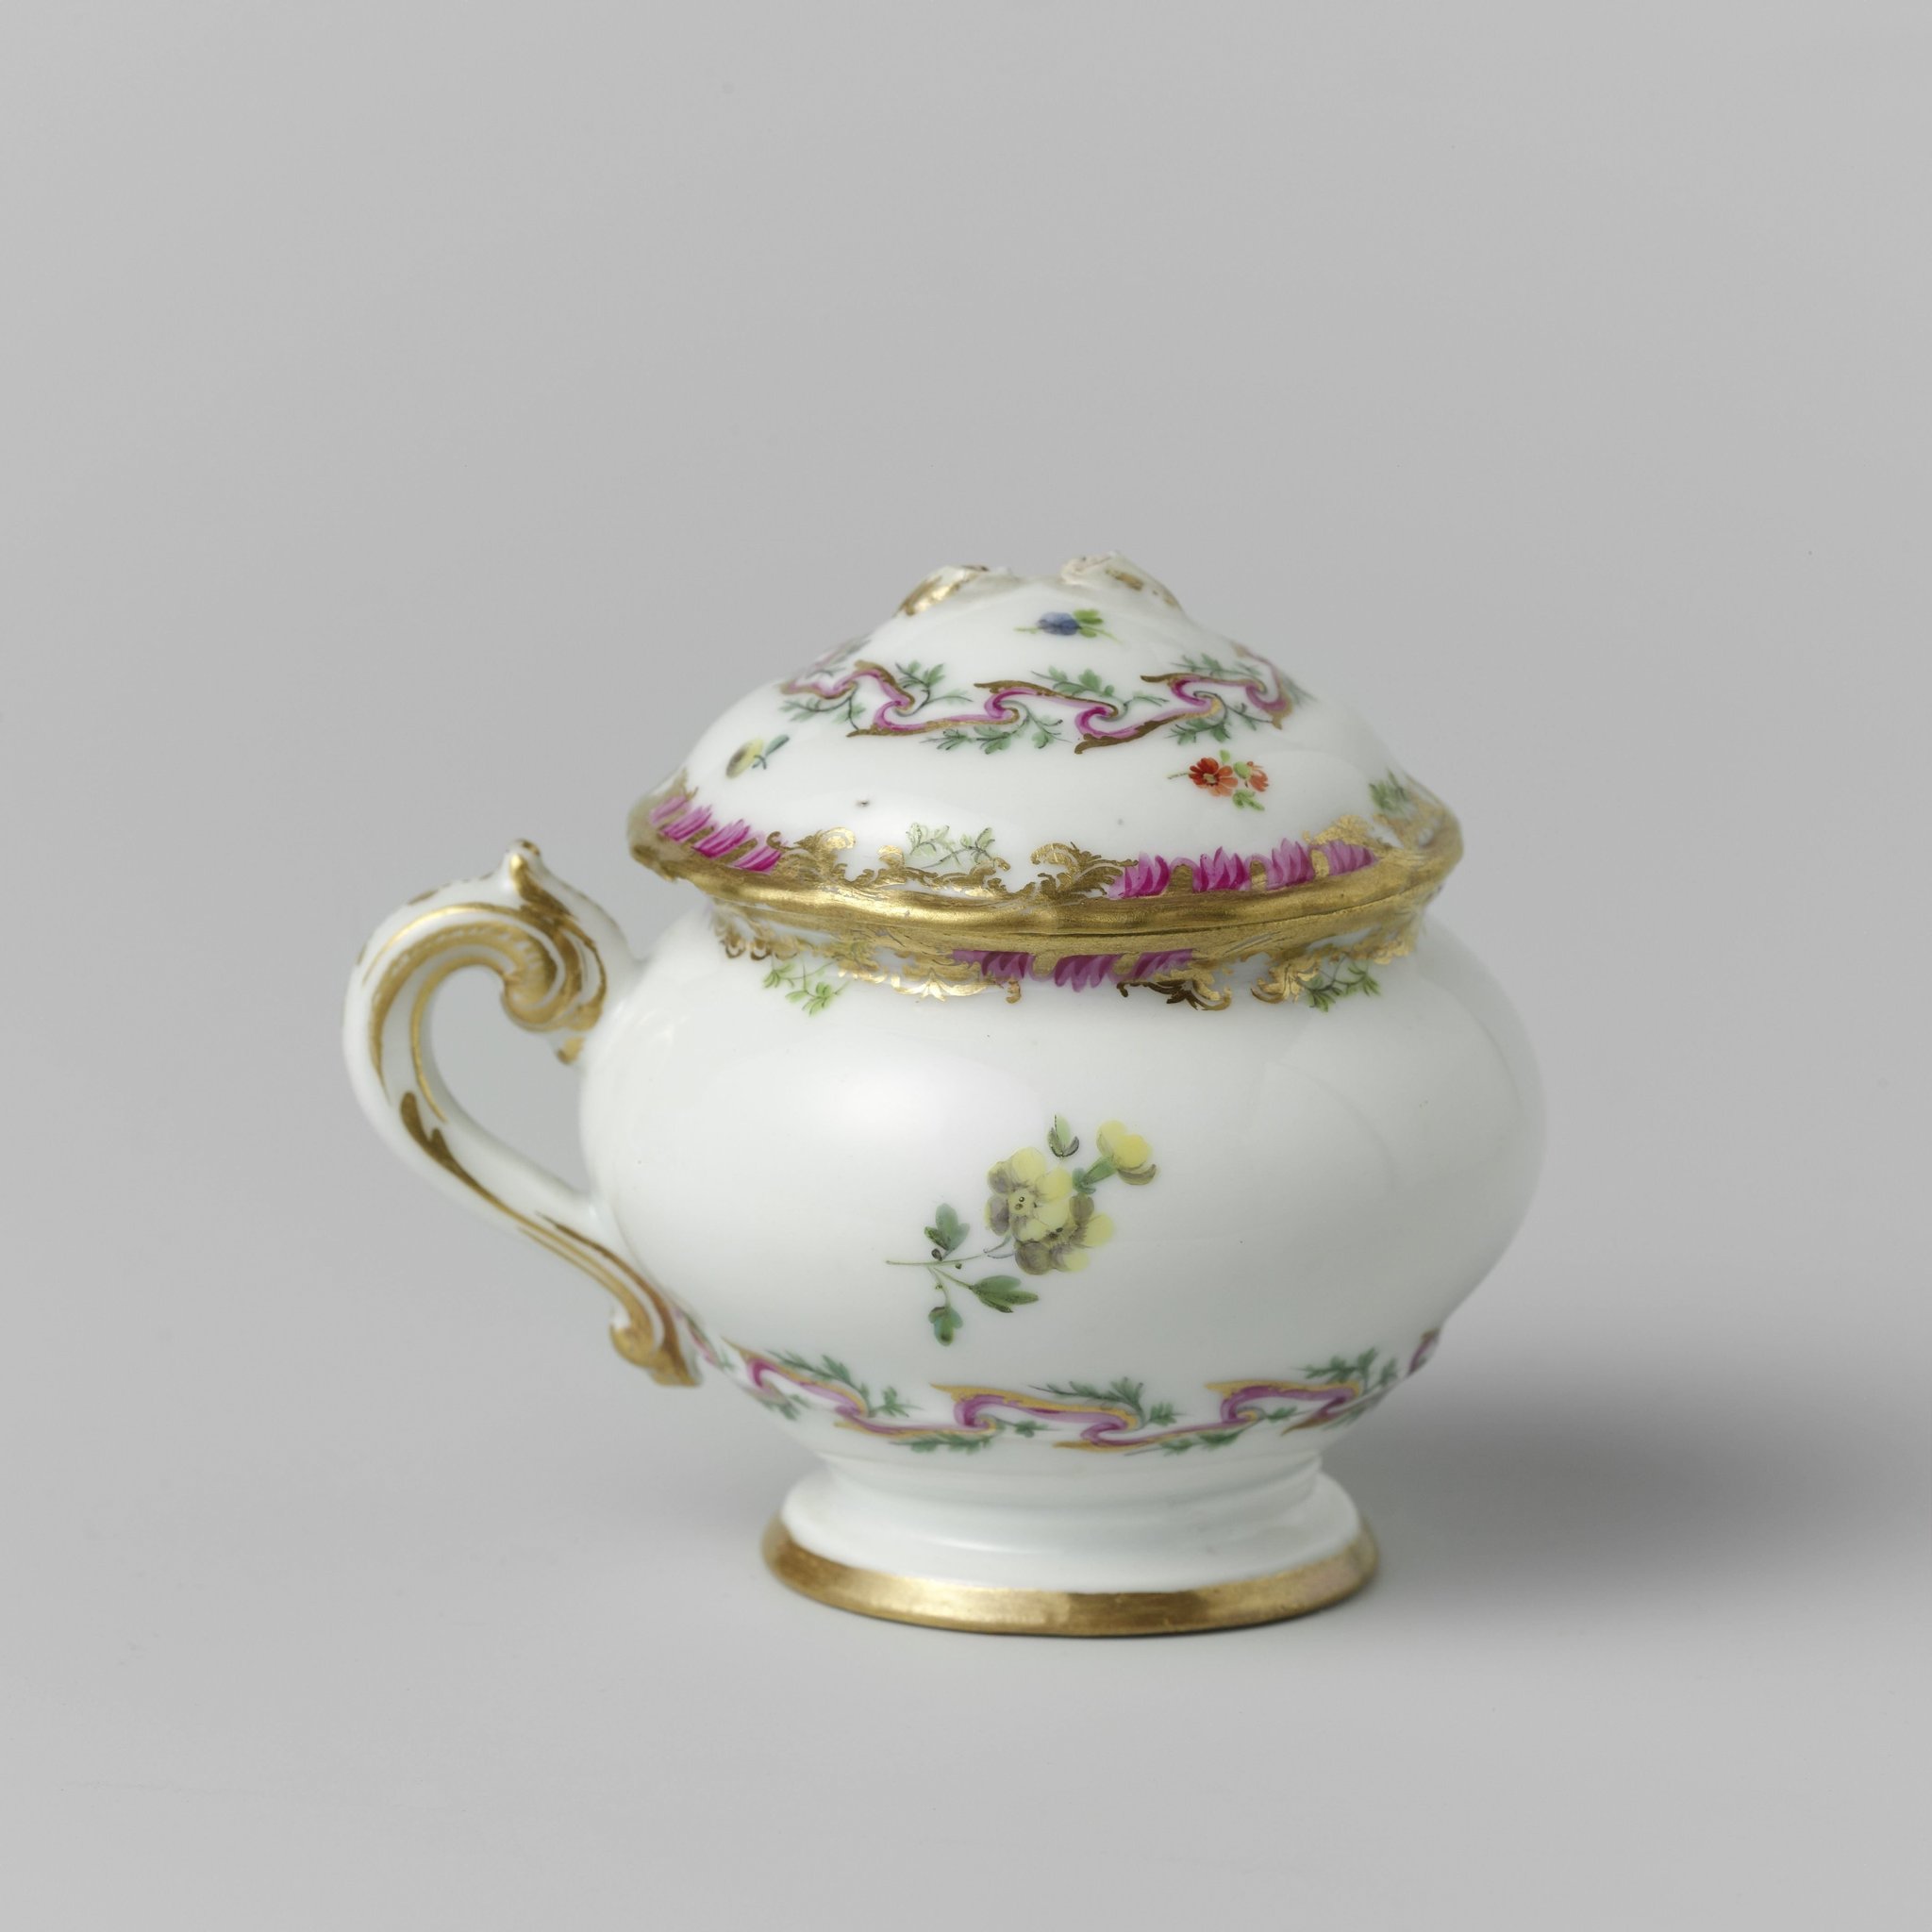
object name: pot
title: Pasteipot, rond, met deksel en oor, behorend bij een servies met geslingerd lintmotief met bladertakken, bloemboeketten en gestrooide bloemtakken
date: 1780-1820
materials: porcelain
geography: amsterdam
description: Pasteipot, rond, met deksel en oor, behorend bij een servies van porselein met geslingerd motief in paars en goud met groene bladertakken, bloemboeketten en gestrooide bloemtakken. Randen lichtgegolfd met decoratie in goud met paars bladmotief waartussen groen gekruist bladmotief. Gemerkt: M.O.L. en AMSTEL. Serie van elf stuks. Knop van deksel ontbreekt.